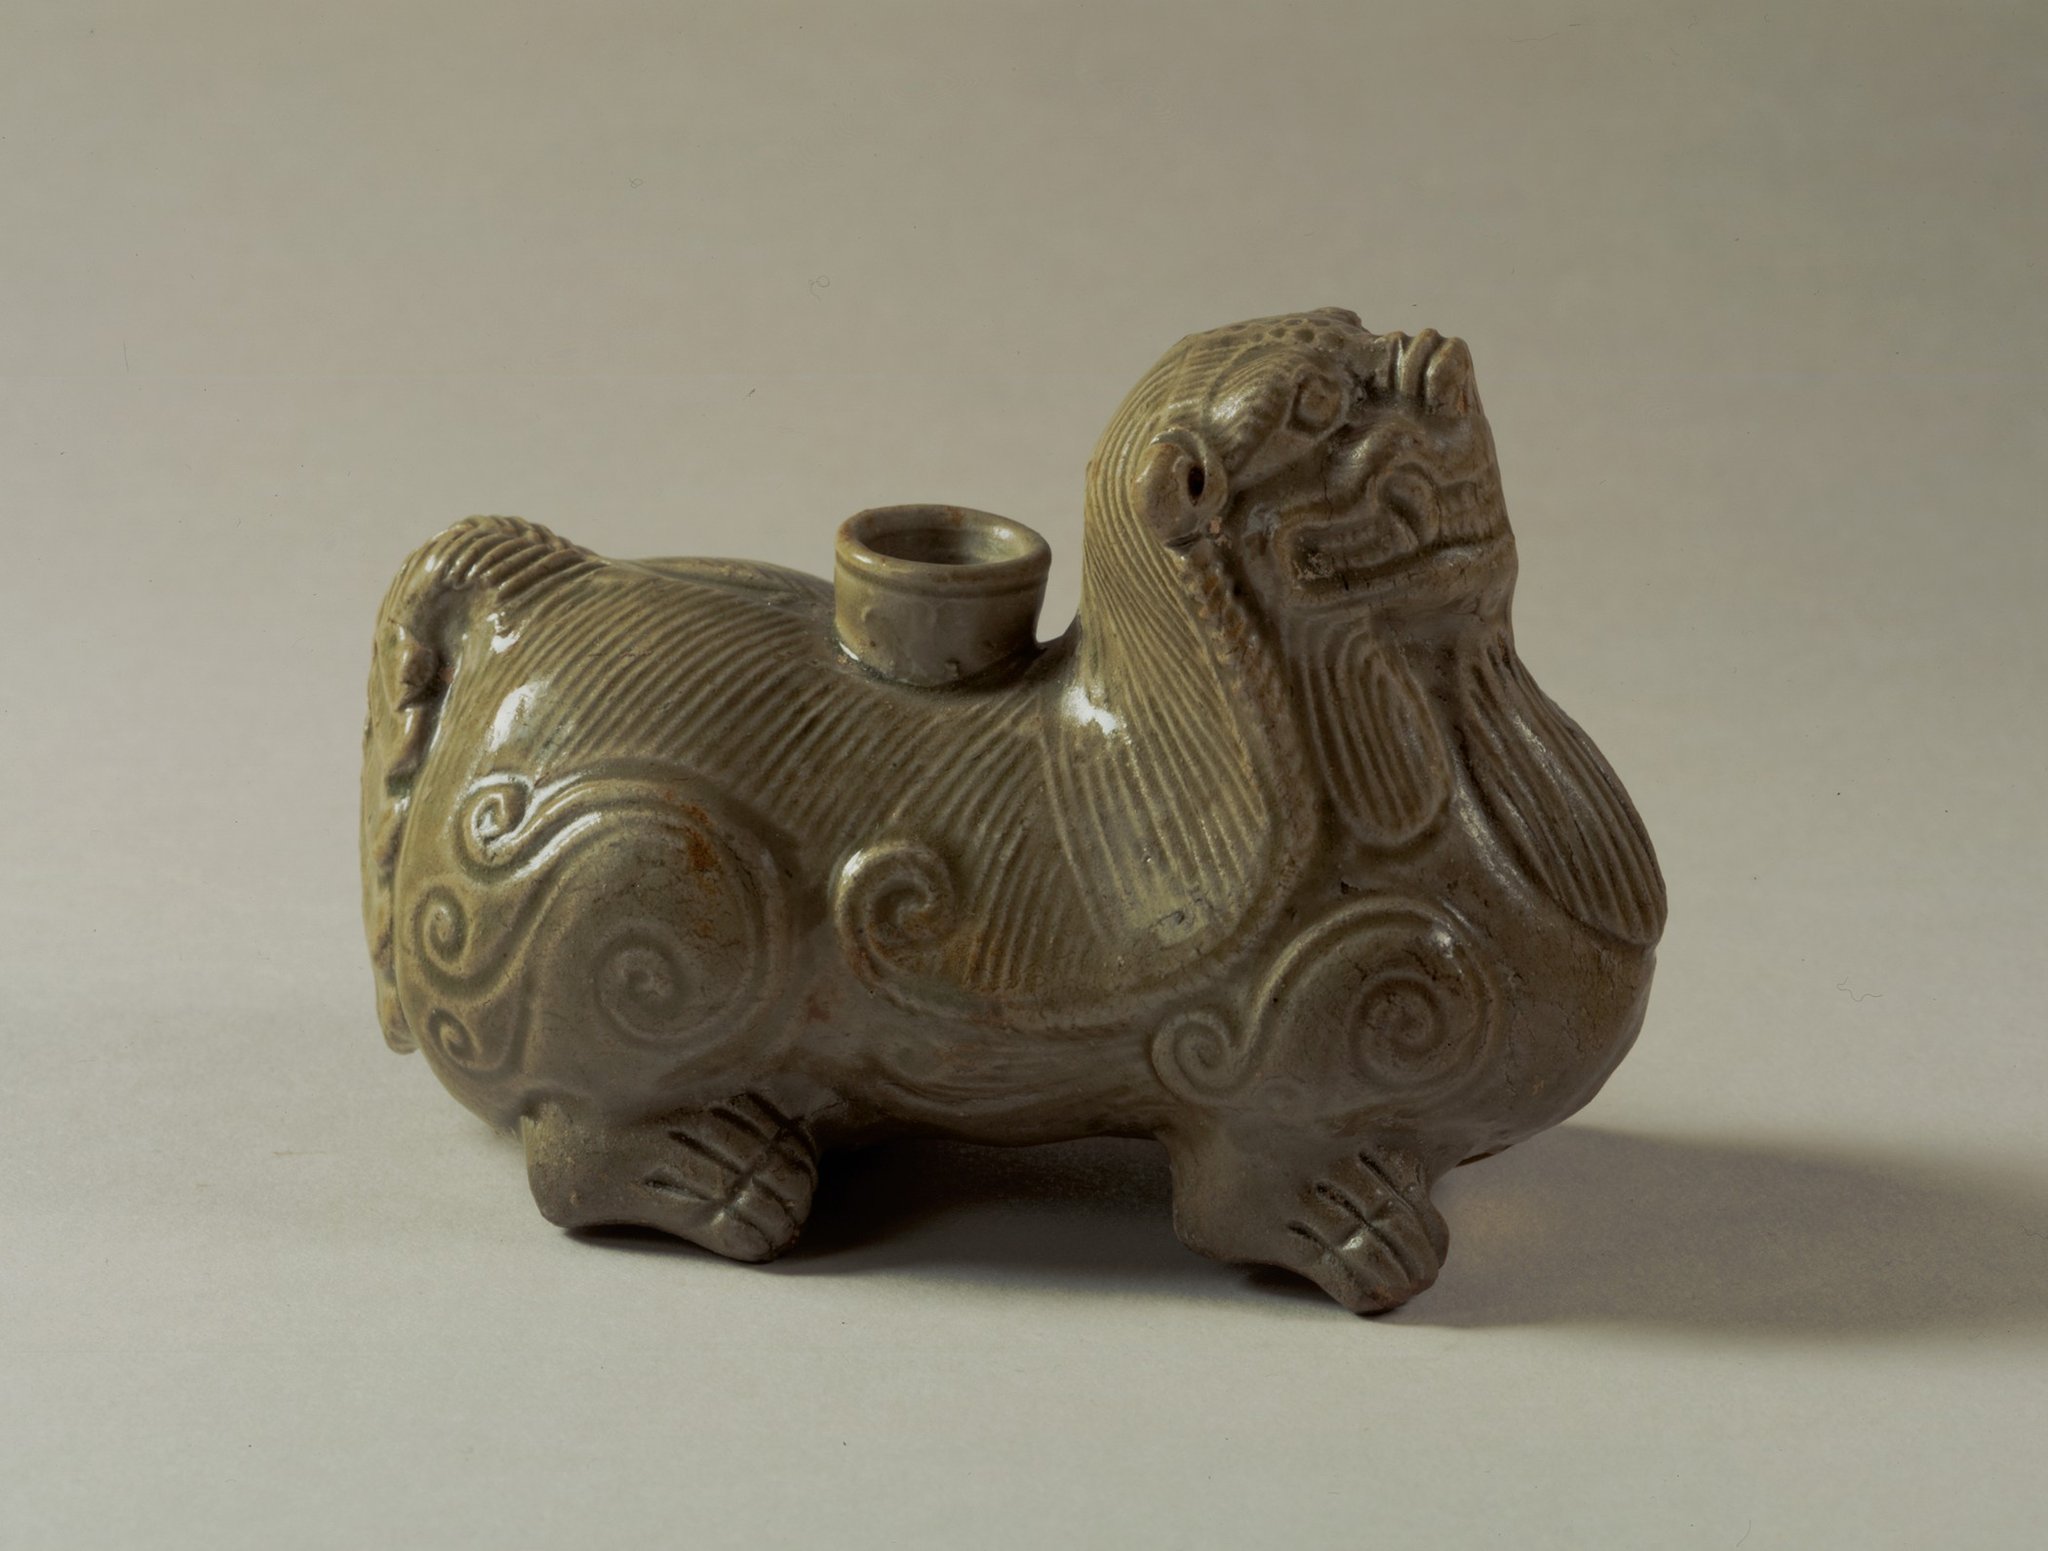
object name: candle stand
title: Candle Stand in the Shape of a Fantastic Animal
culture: chinese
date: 265-316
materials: glaze, stoneware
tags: animals